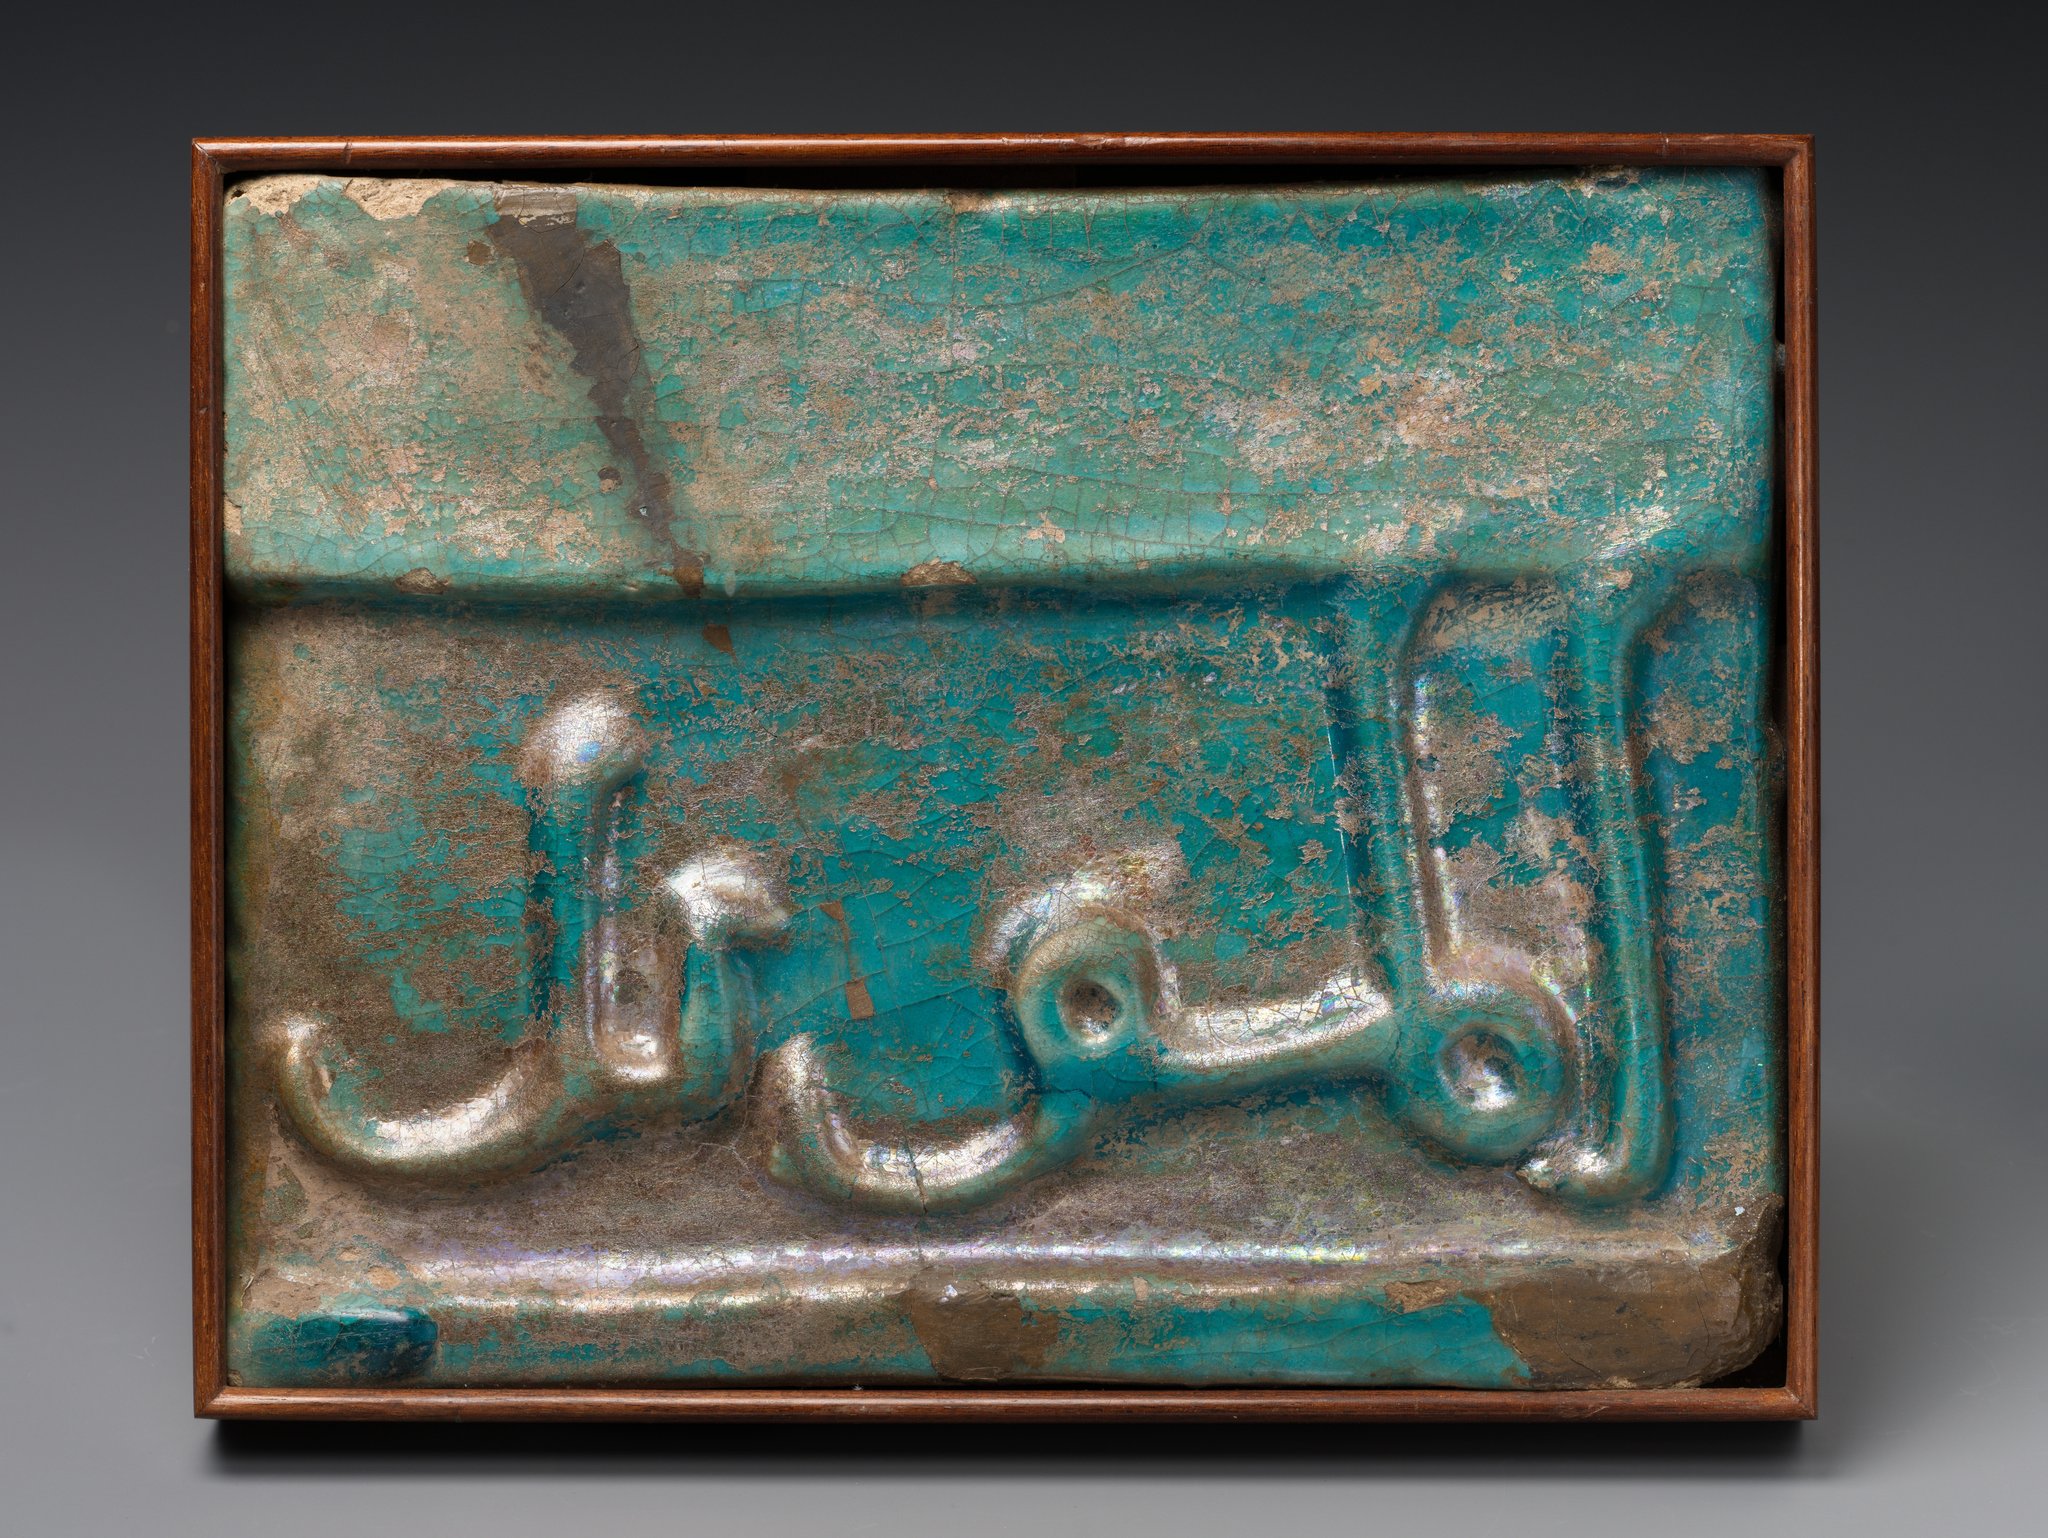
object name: tile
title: Tile from a Frieze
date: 1201-1300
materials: stonepaste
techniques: glazing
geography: syria